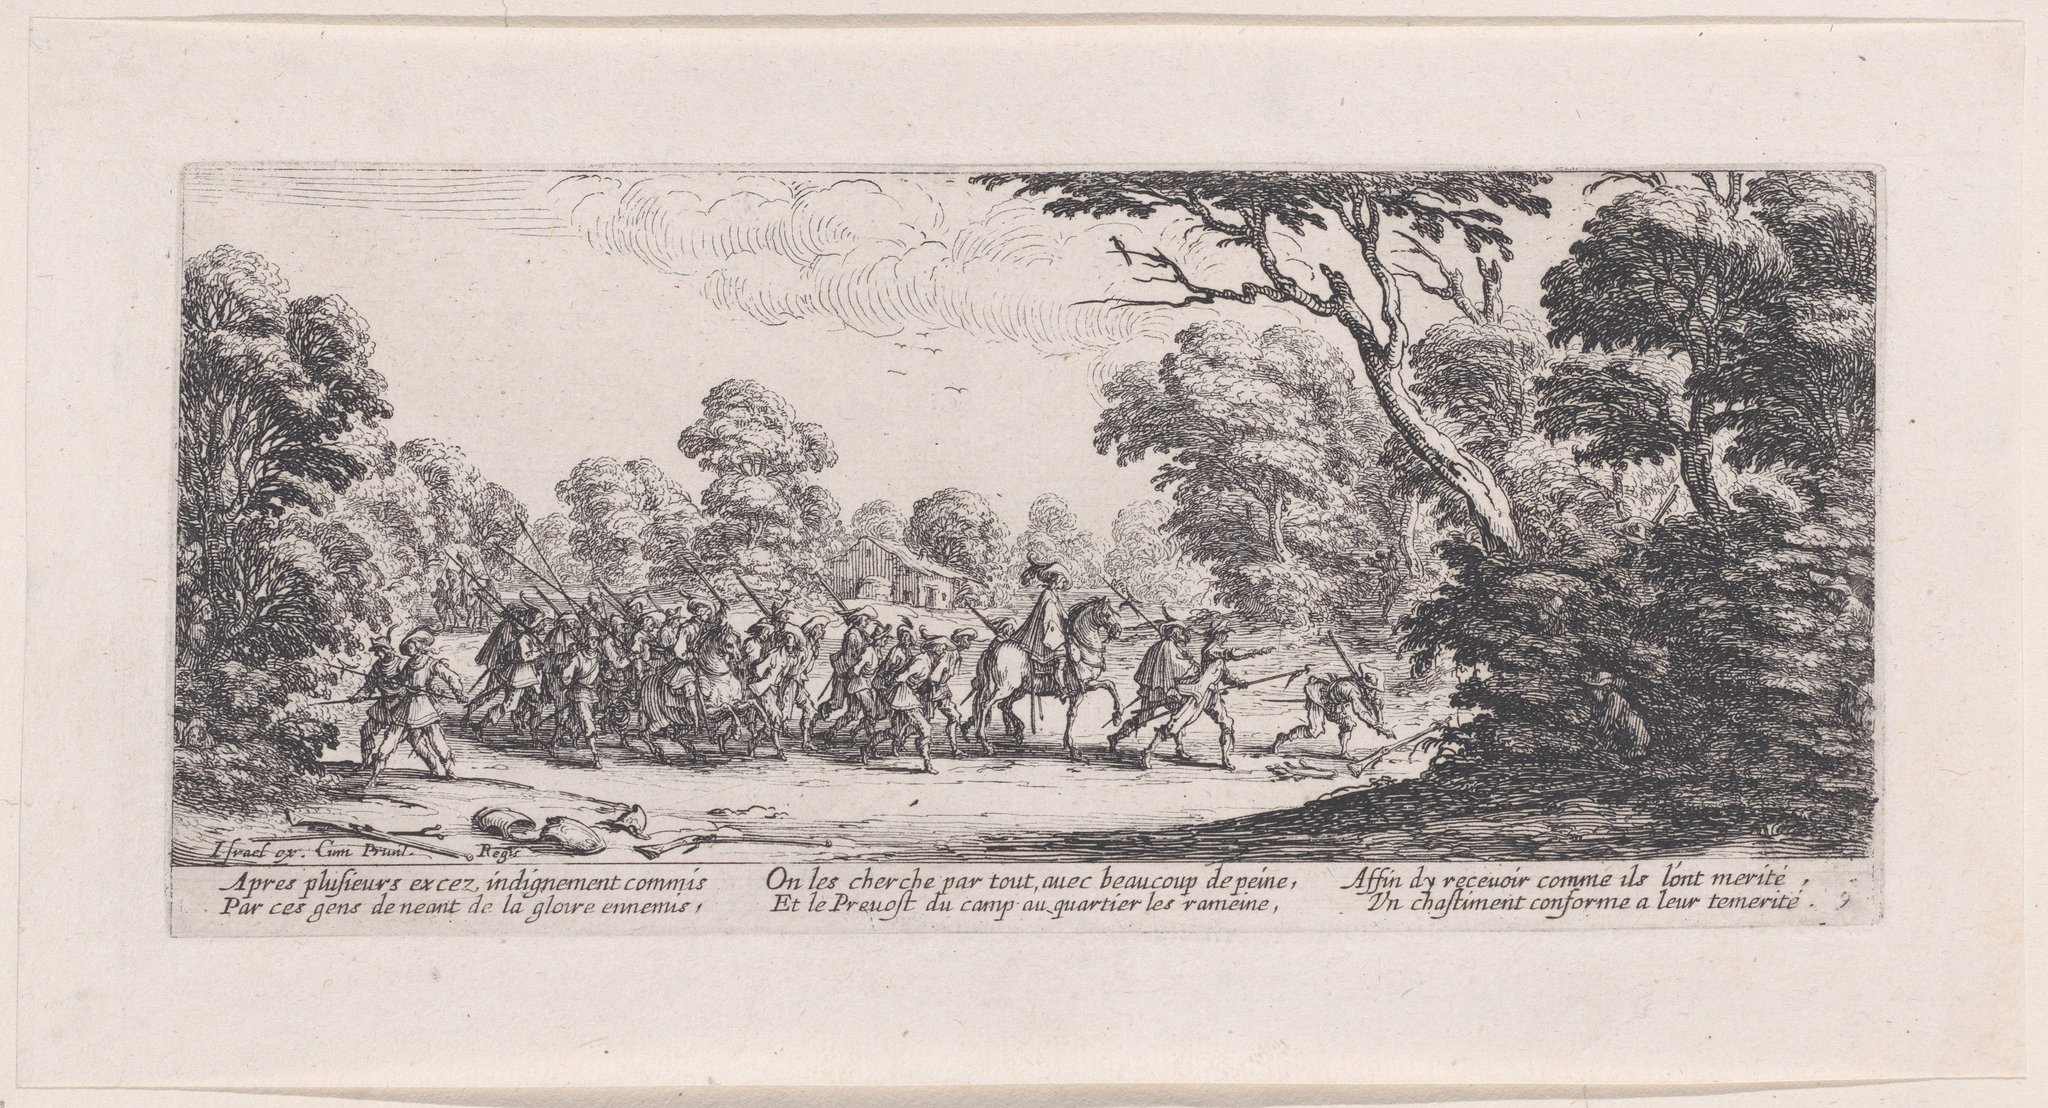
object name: print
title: Découverte des Malfaiteurs (The Discovery of the Criminals), plate 9 from "Les Misères et les Mal-Heures de la Guerre" (The Miseries and Misfortunes of War)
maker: jacques callot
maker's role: artist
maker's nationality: french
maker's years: 1592-1635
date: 1633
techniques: etching